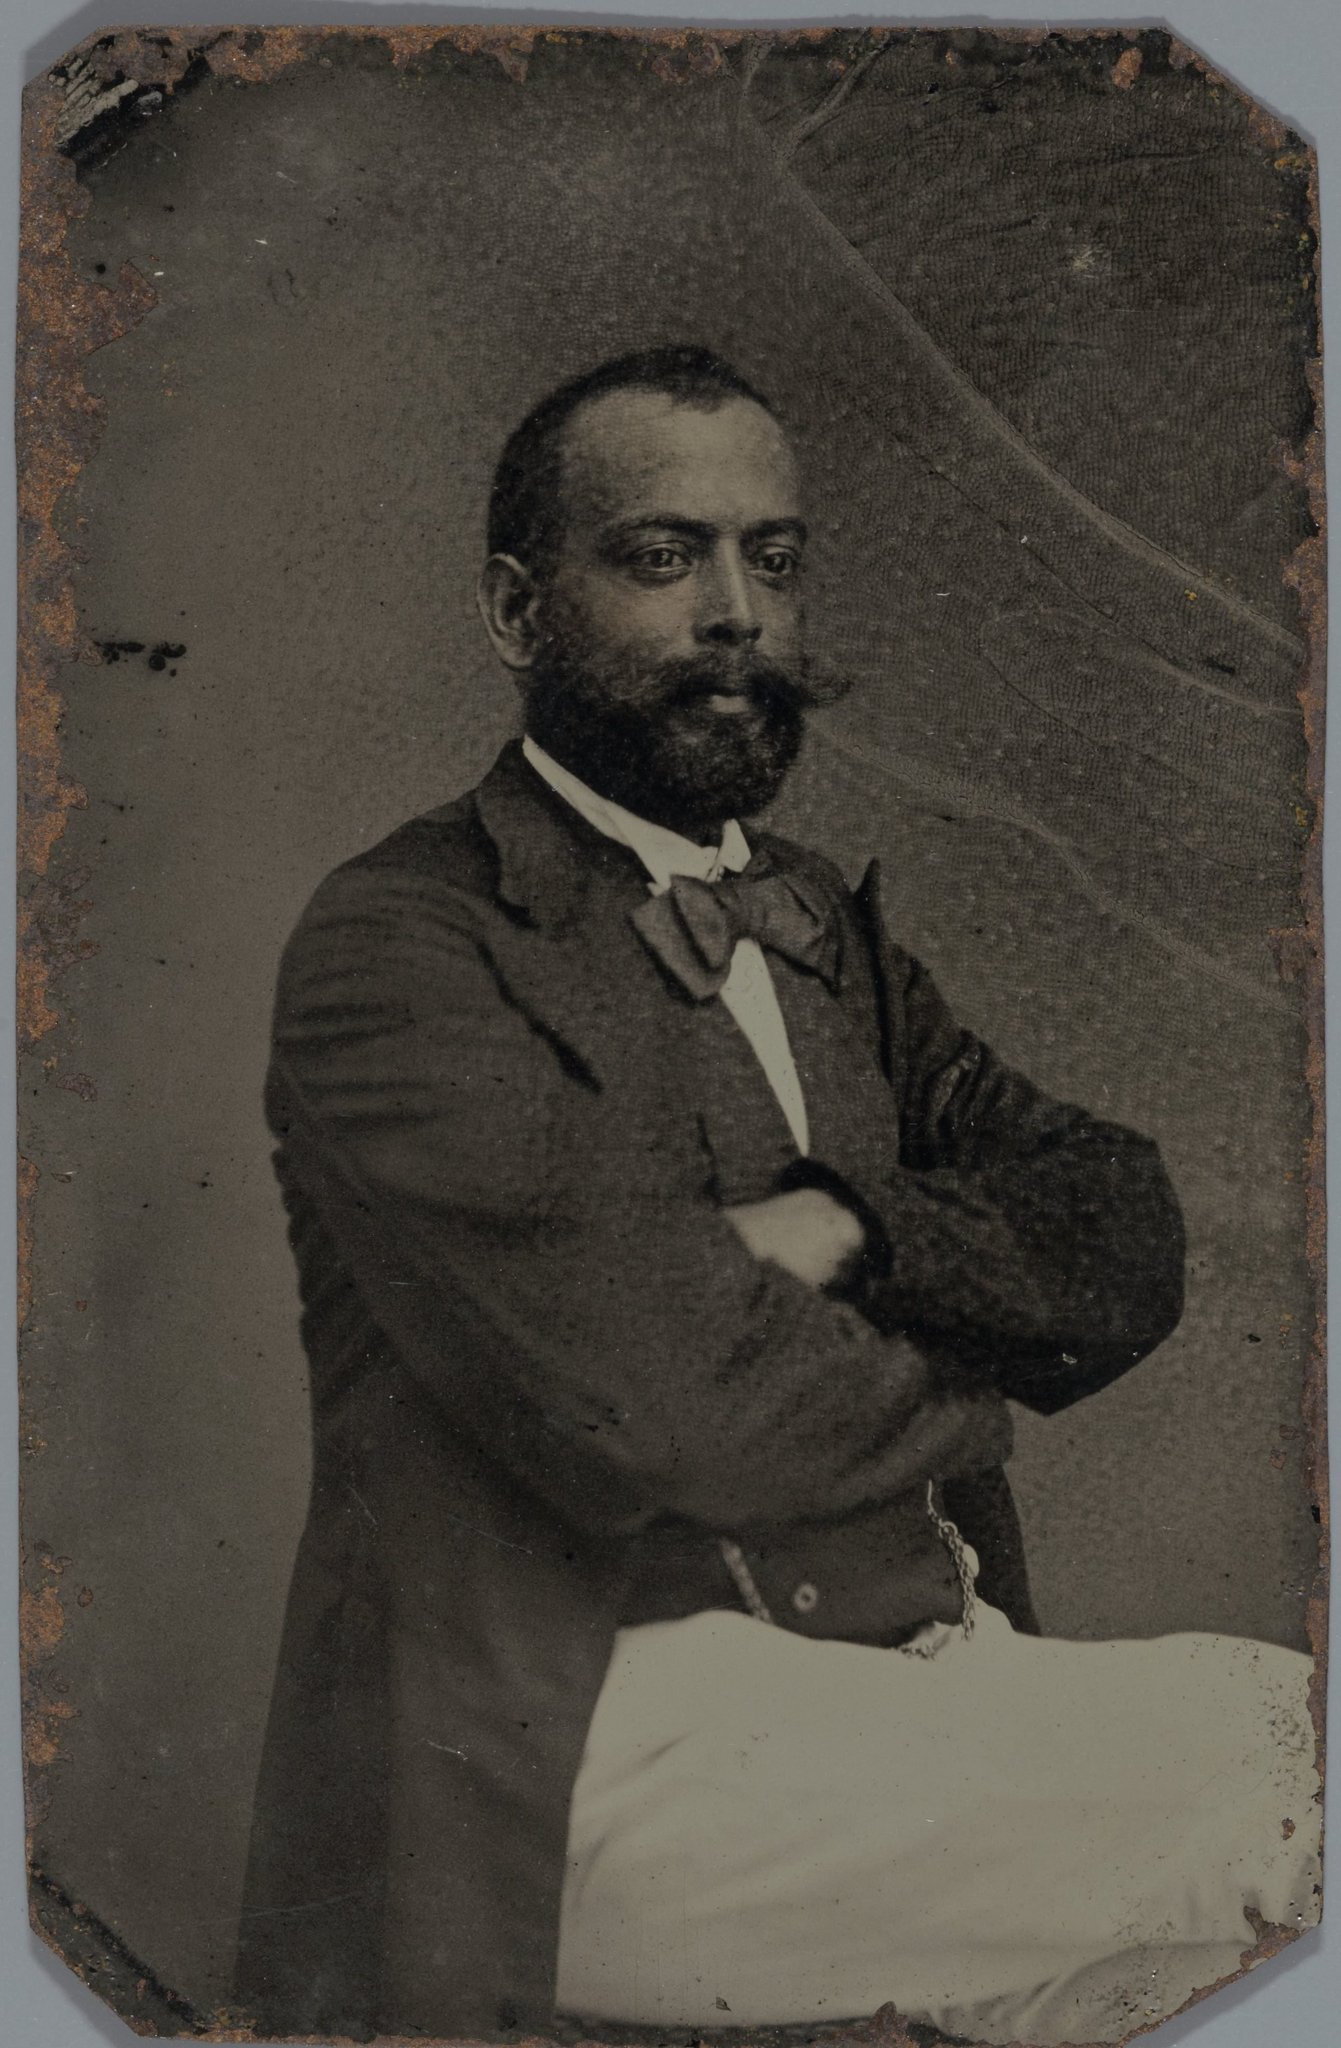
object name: photograph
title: Portret van Charles Christiaan Walther de Hart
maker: d. lawrence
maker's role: fotograaf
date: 1876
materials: metal, paper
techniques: ferrotyping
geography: paramaribo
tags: suriname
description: Portret van Charles Christiaan Walther de Hart, de broer van Maria Louisa van de Hart.